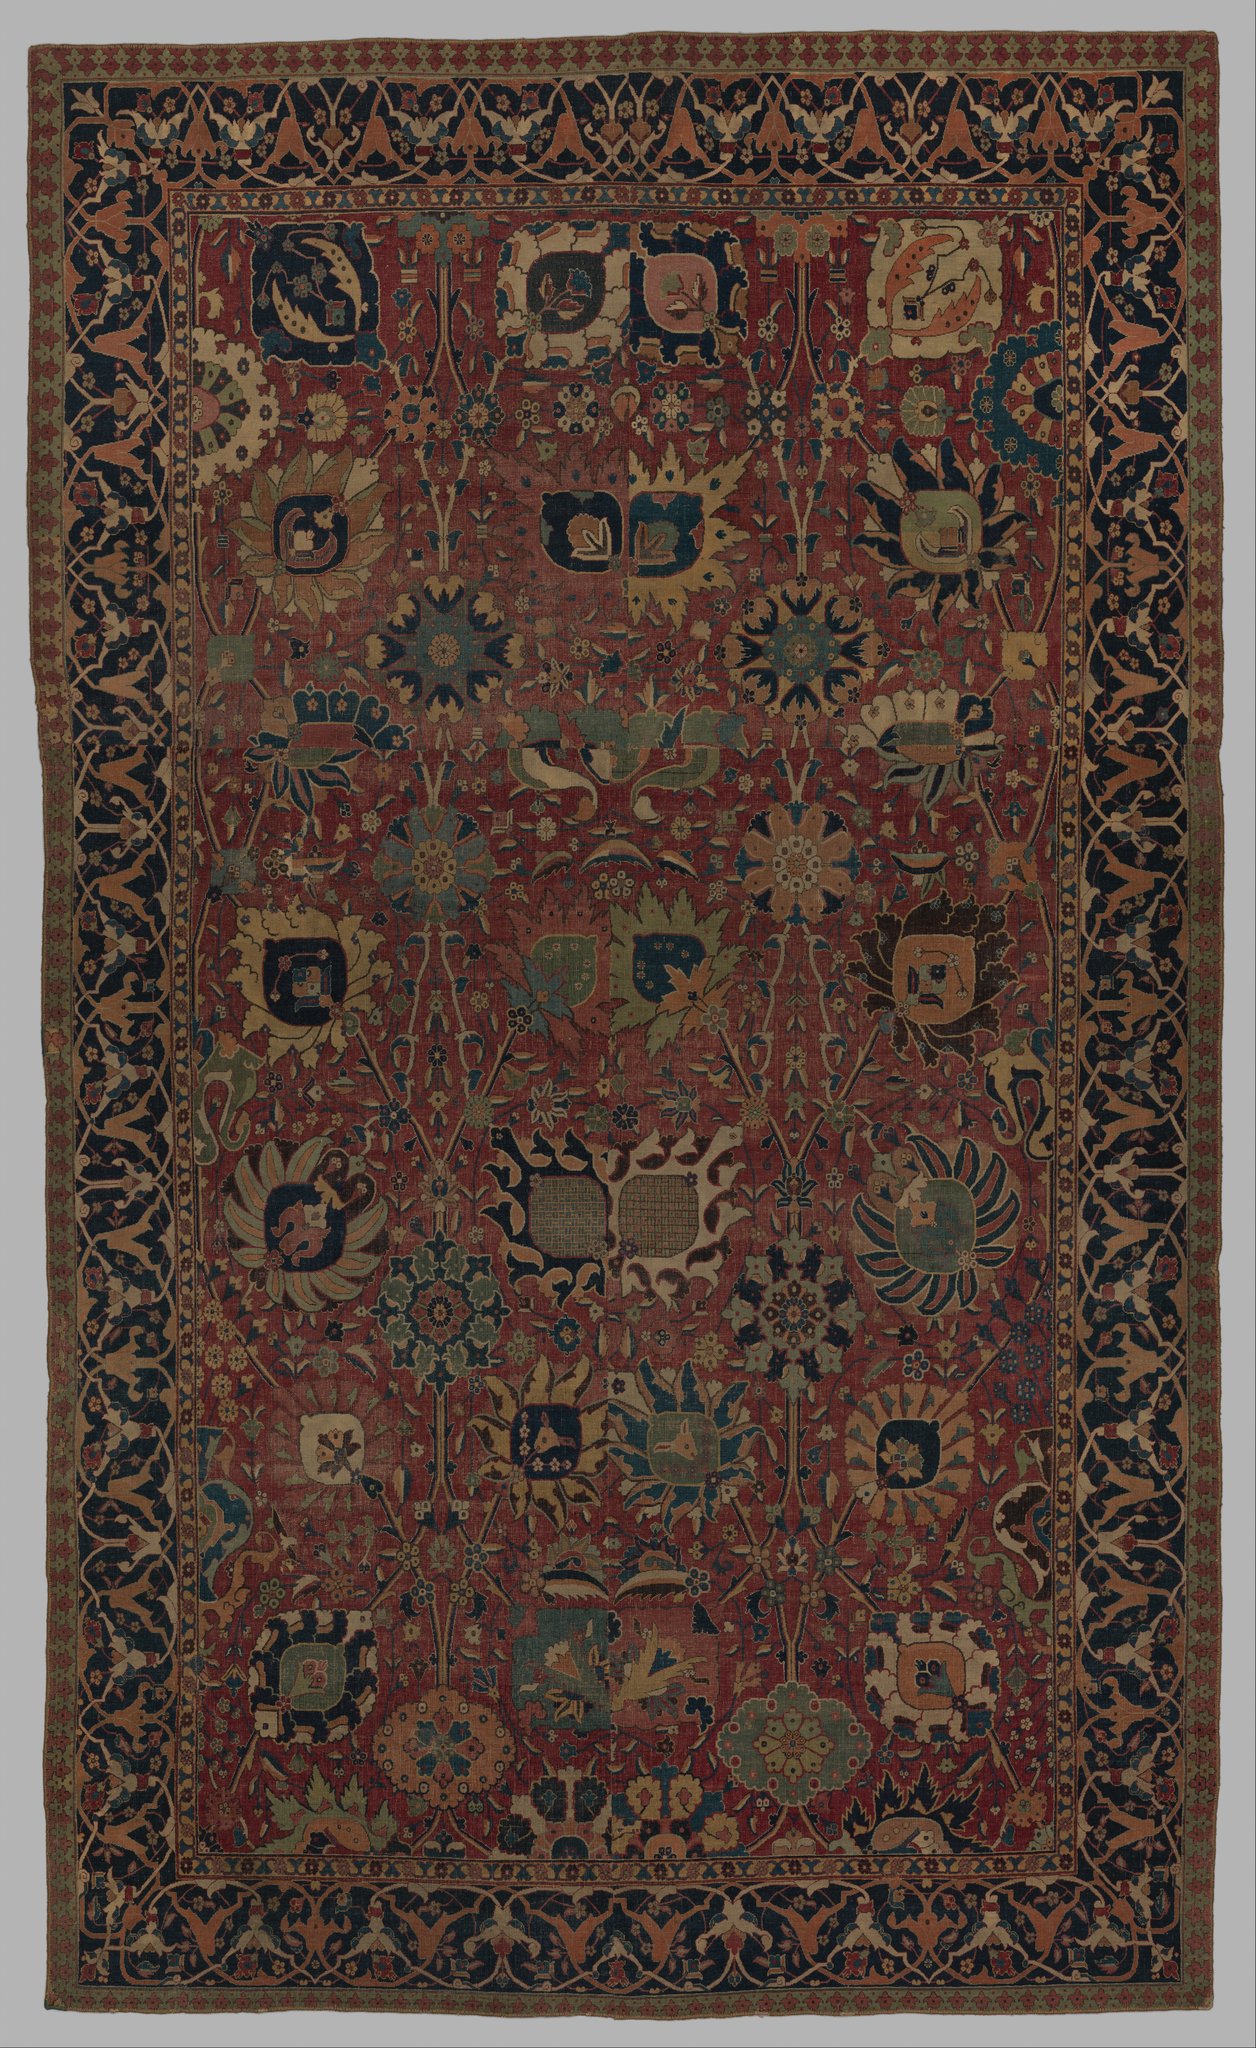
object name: carpet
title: Vase Carpet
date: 1601-1700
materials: cotton, wool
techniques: asymmetrically knotted pile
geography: iran